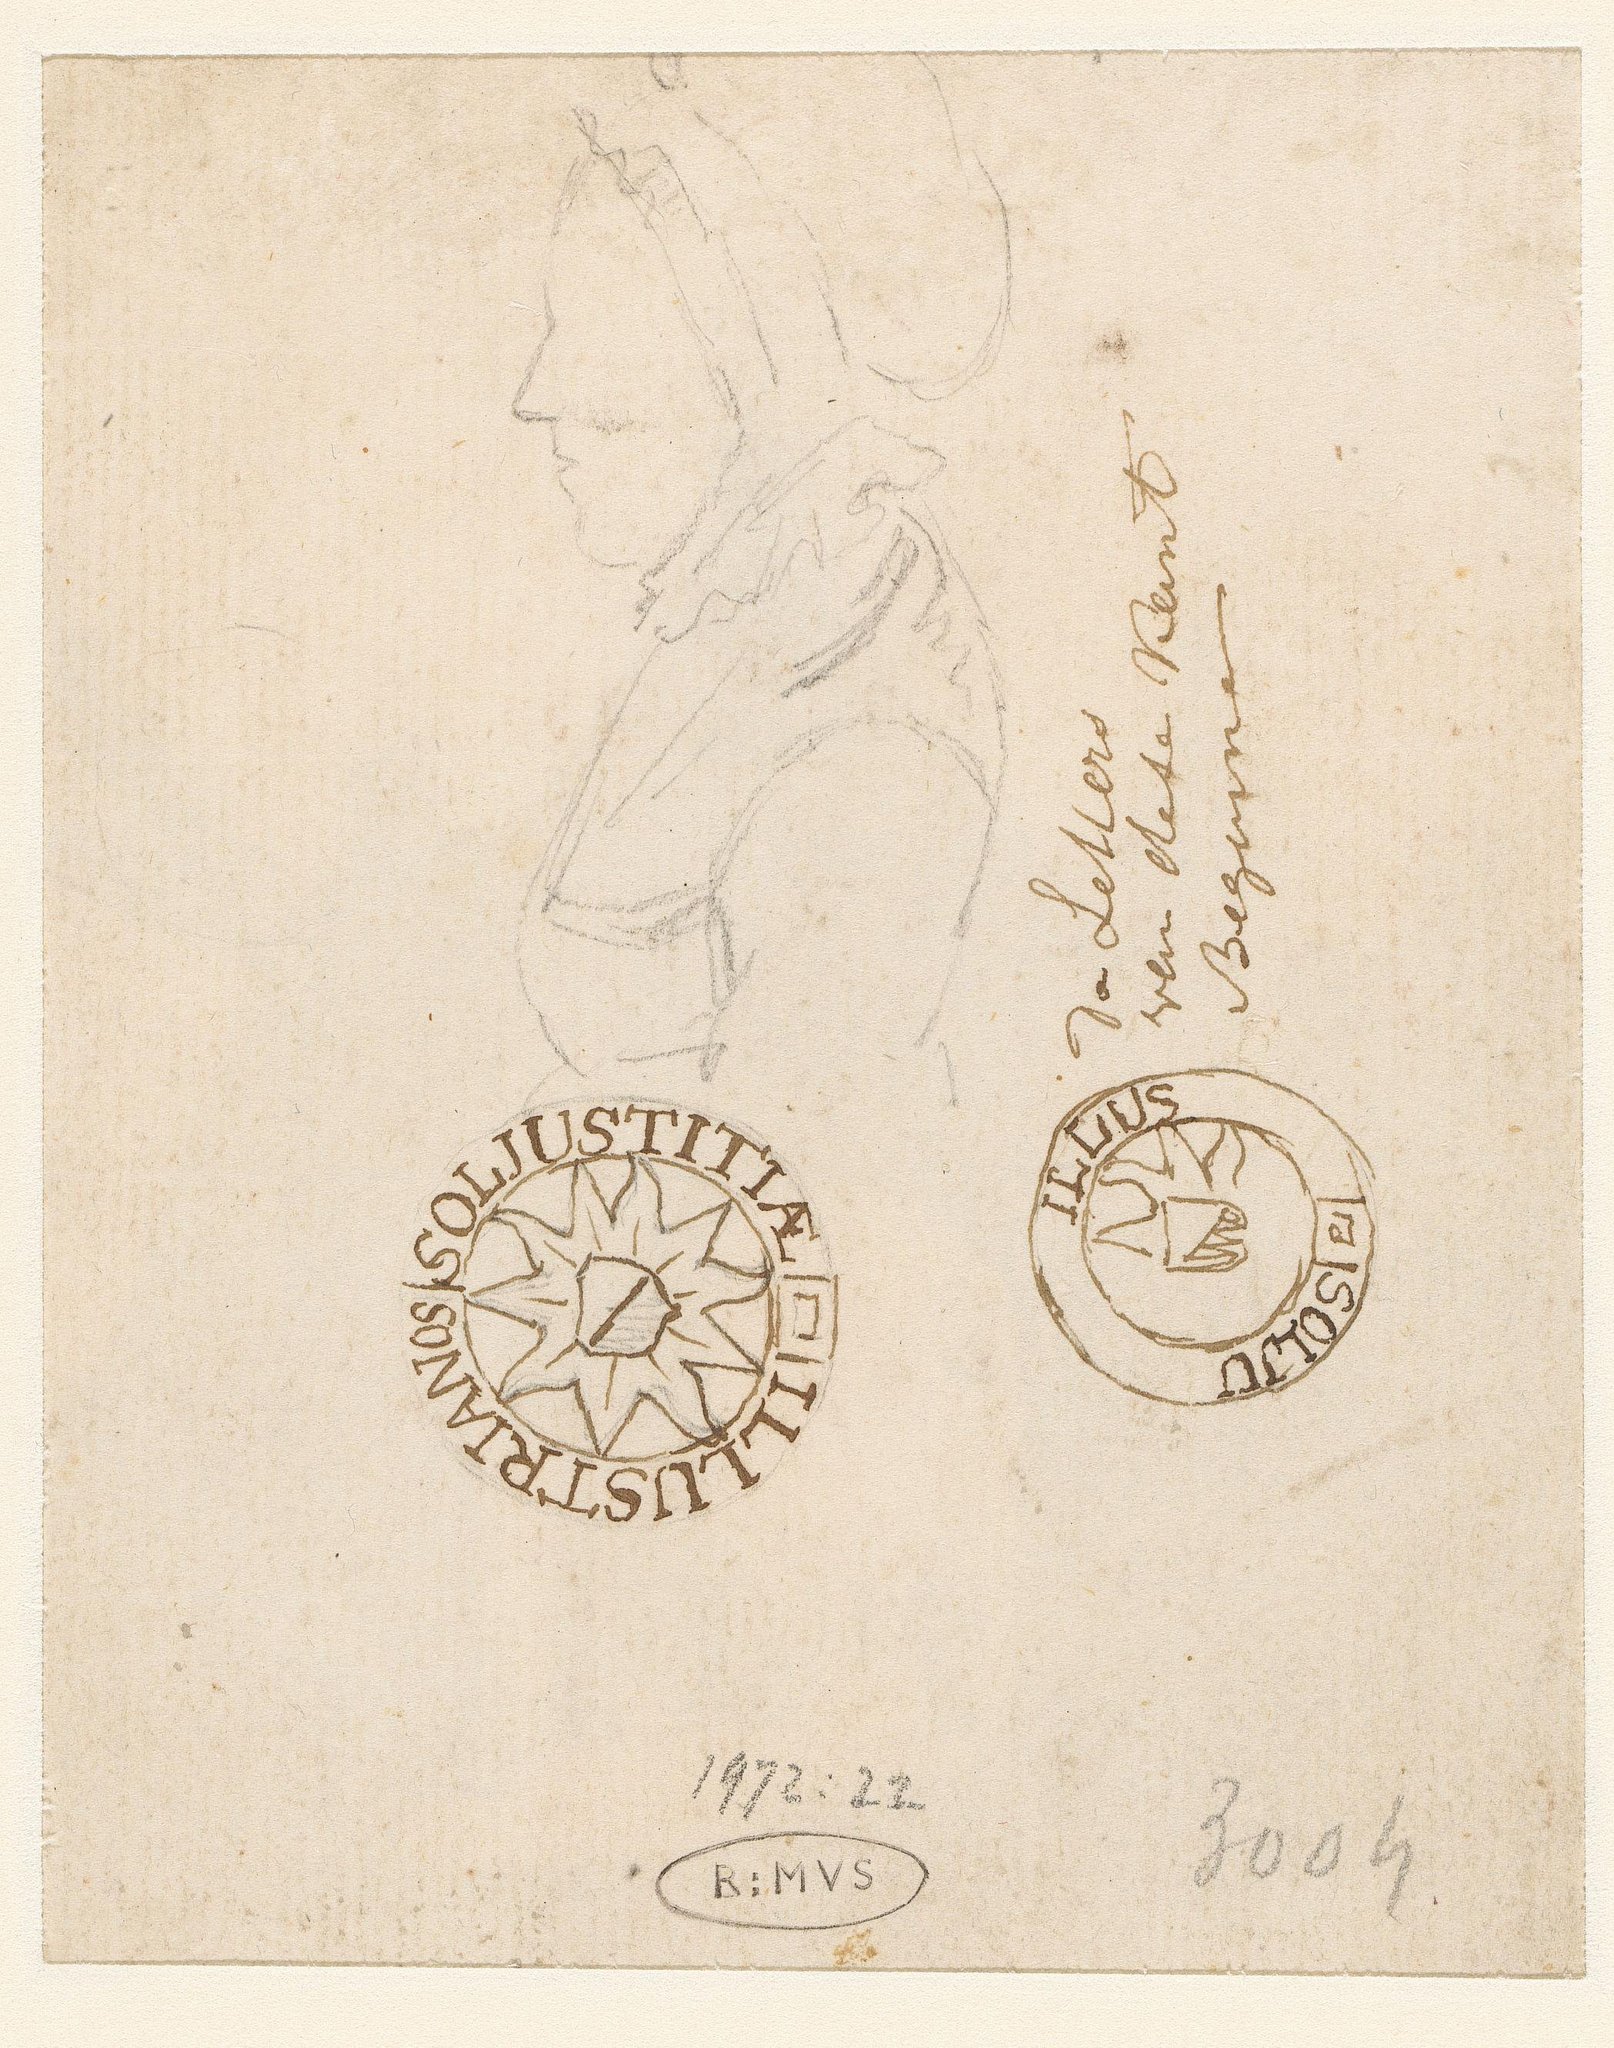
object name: drawing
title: Schets van een vrouw en ontwerpen voor het embleem van de Universiteit van Utrecht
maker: Anonymous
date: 1800-1900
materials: ink, paper, pencil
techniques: pen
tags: university, symbols of particular nations, states, districts, etc., utrecht